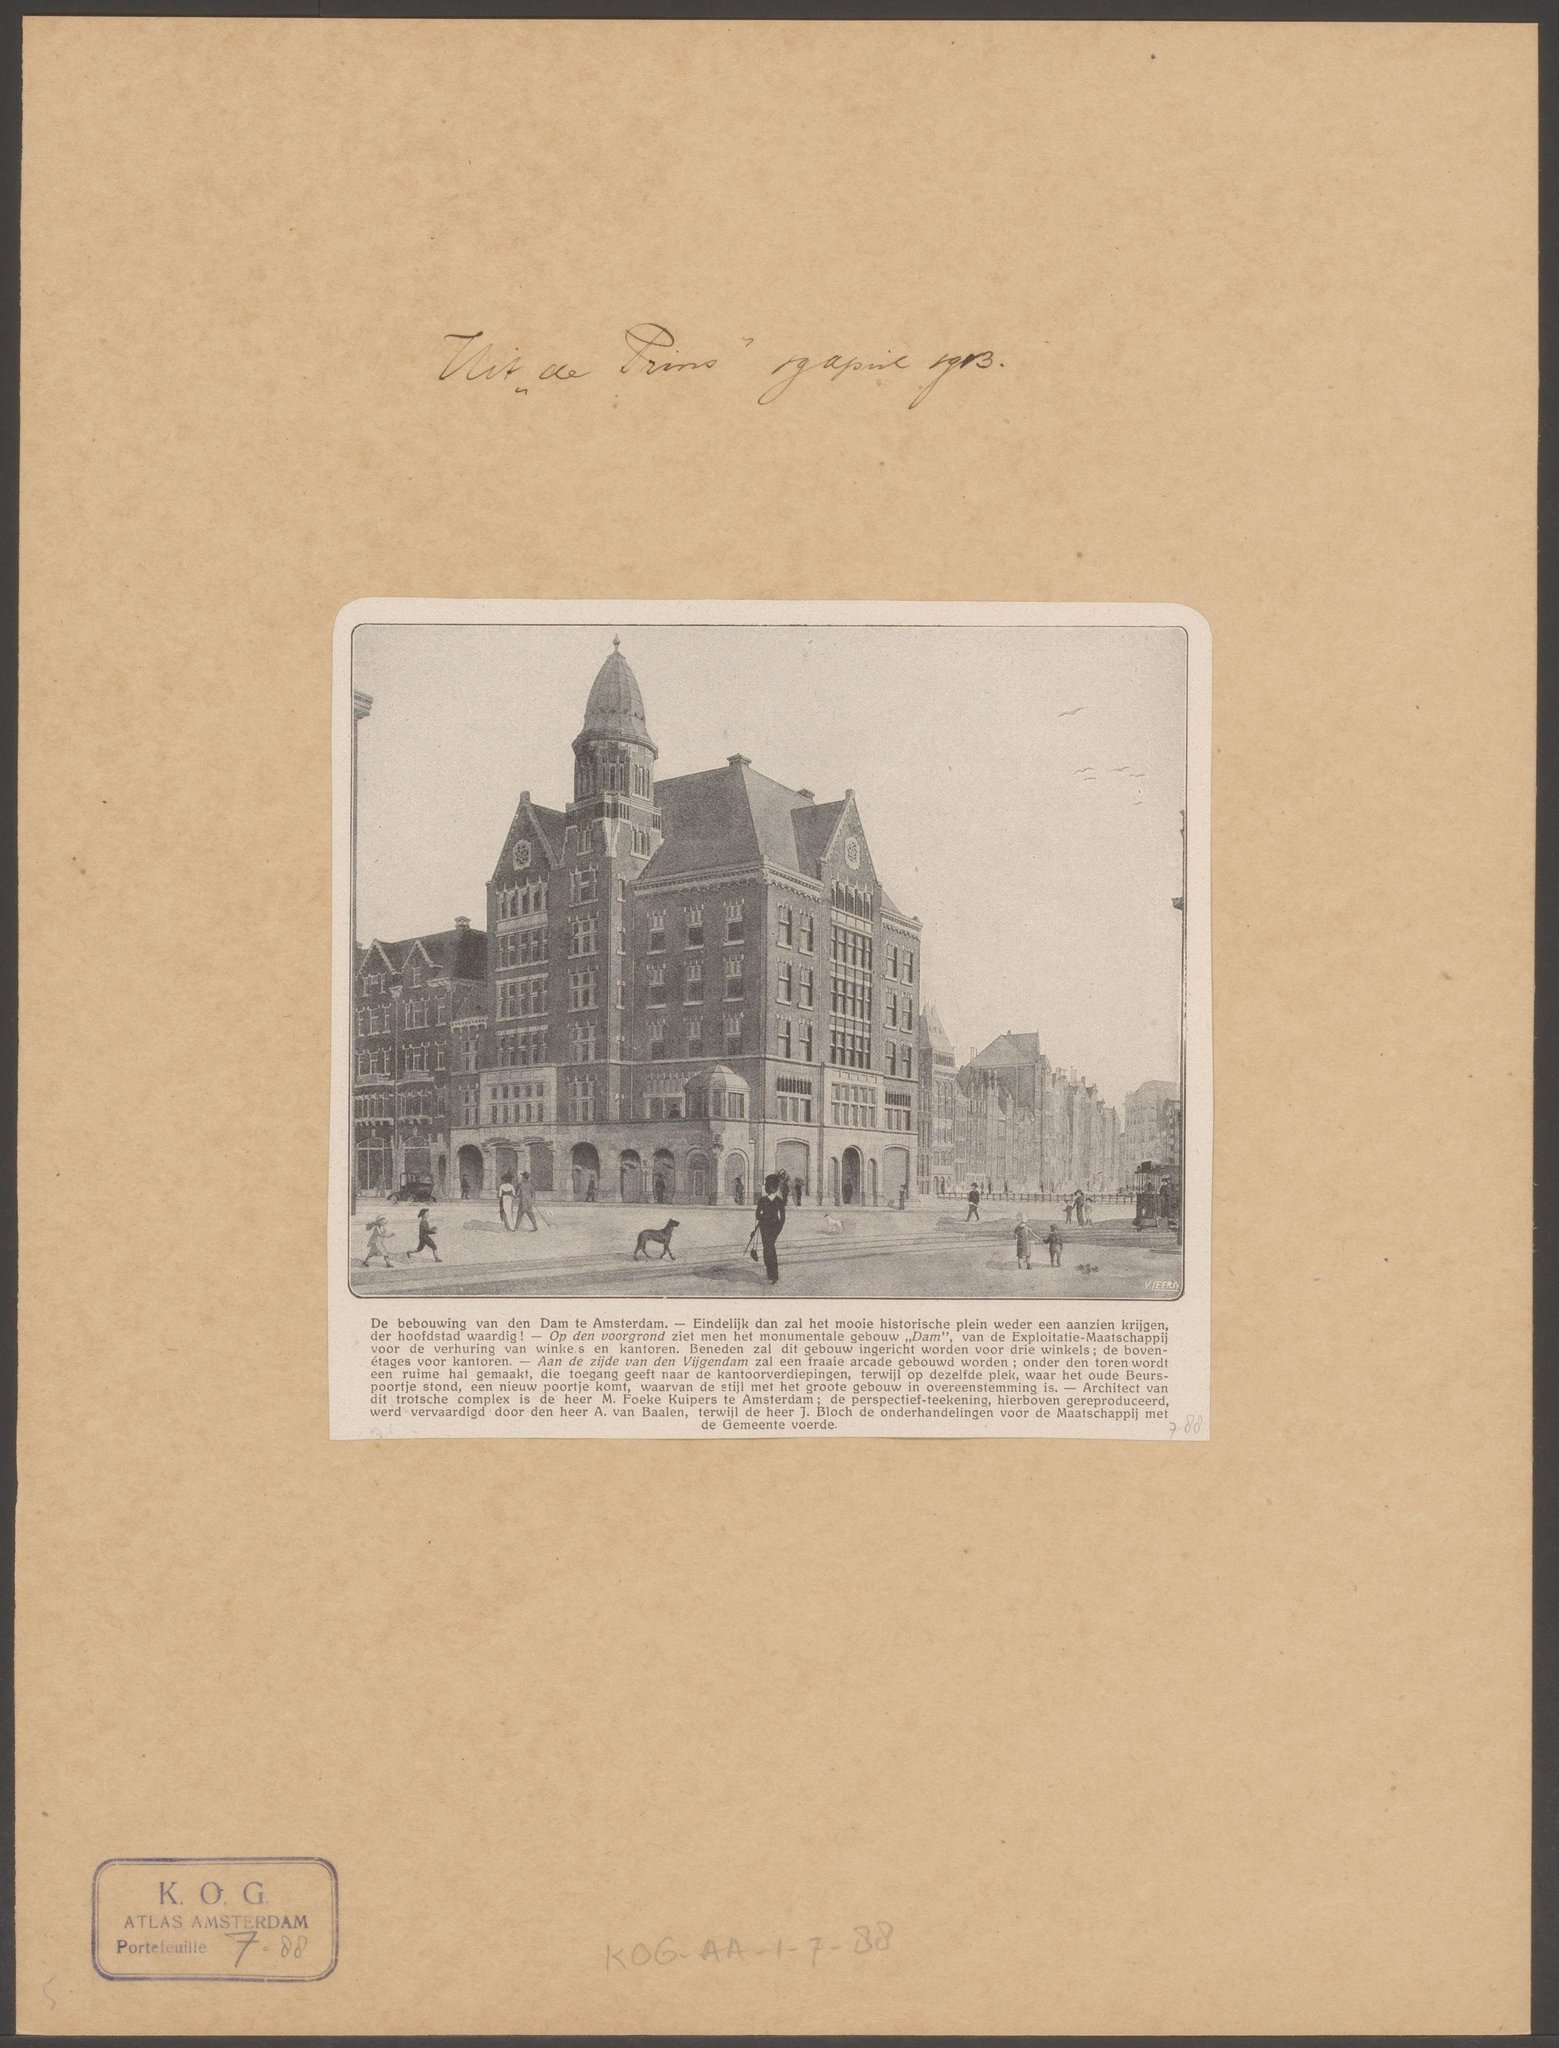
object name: design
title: Ontwerp voor een gebouw op de Dam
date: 1913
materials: paper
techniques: letterpress printing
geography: amsterdam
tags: square, place, circus, etc., city-view in general; 'veduta', façade (of house or building)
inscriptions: collector's mark: ‘7’ Lugt 1641b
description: Fotomechanische afdruk uit: De Prins (1913), 19 april 1913.